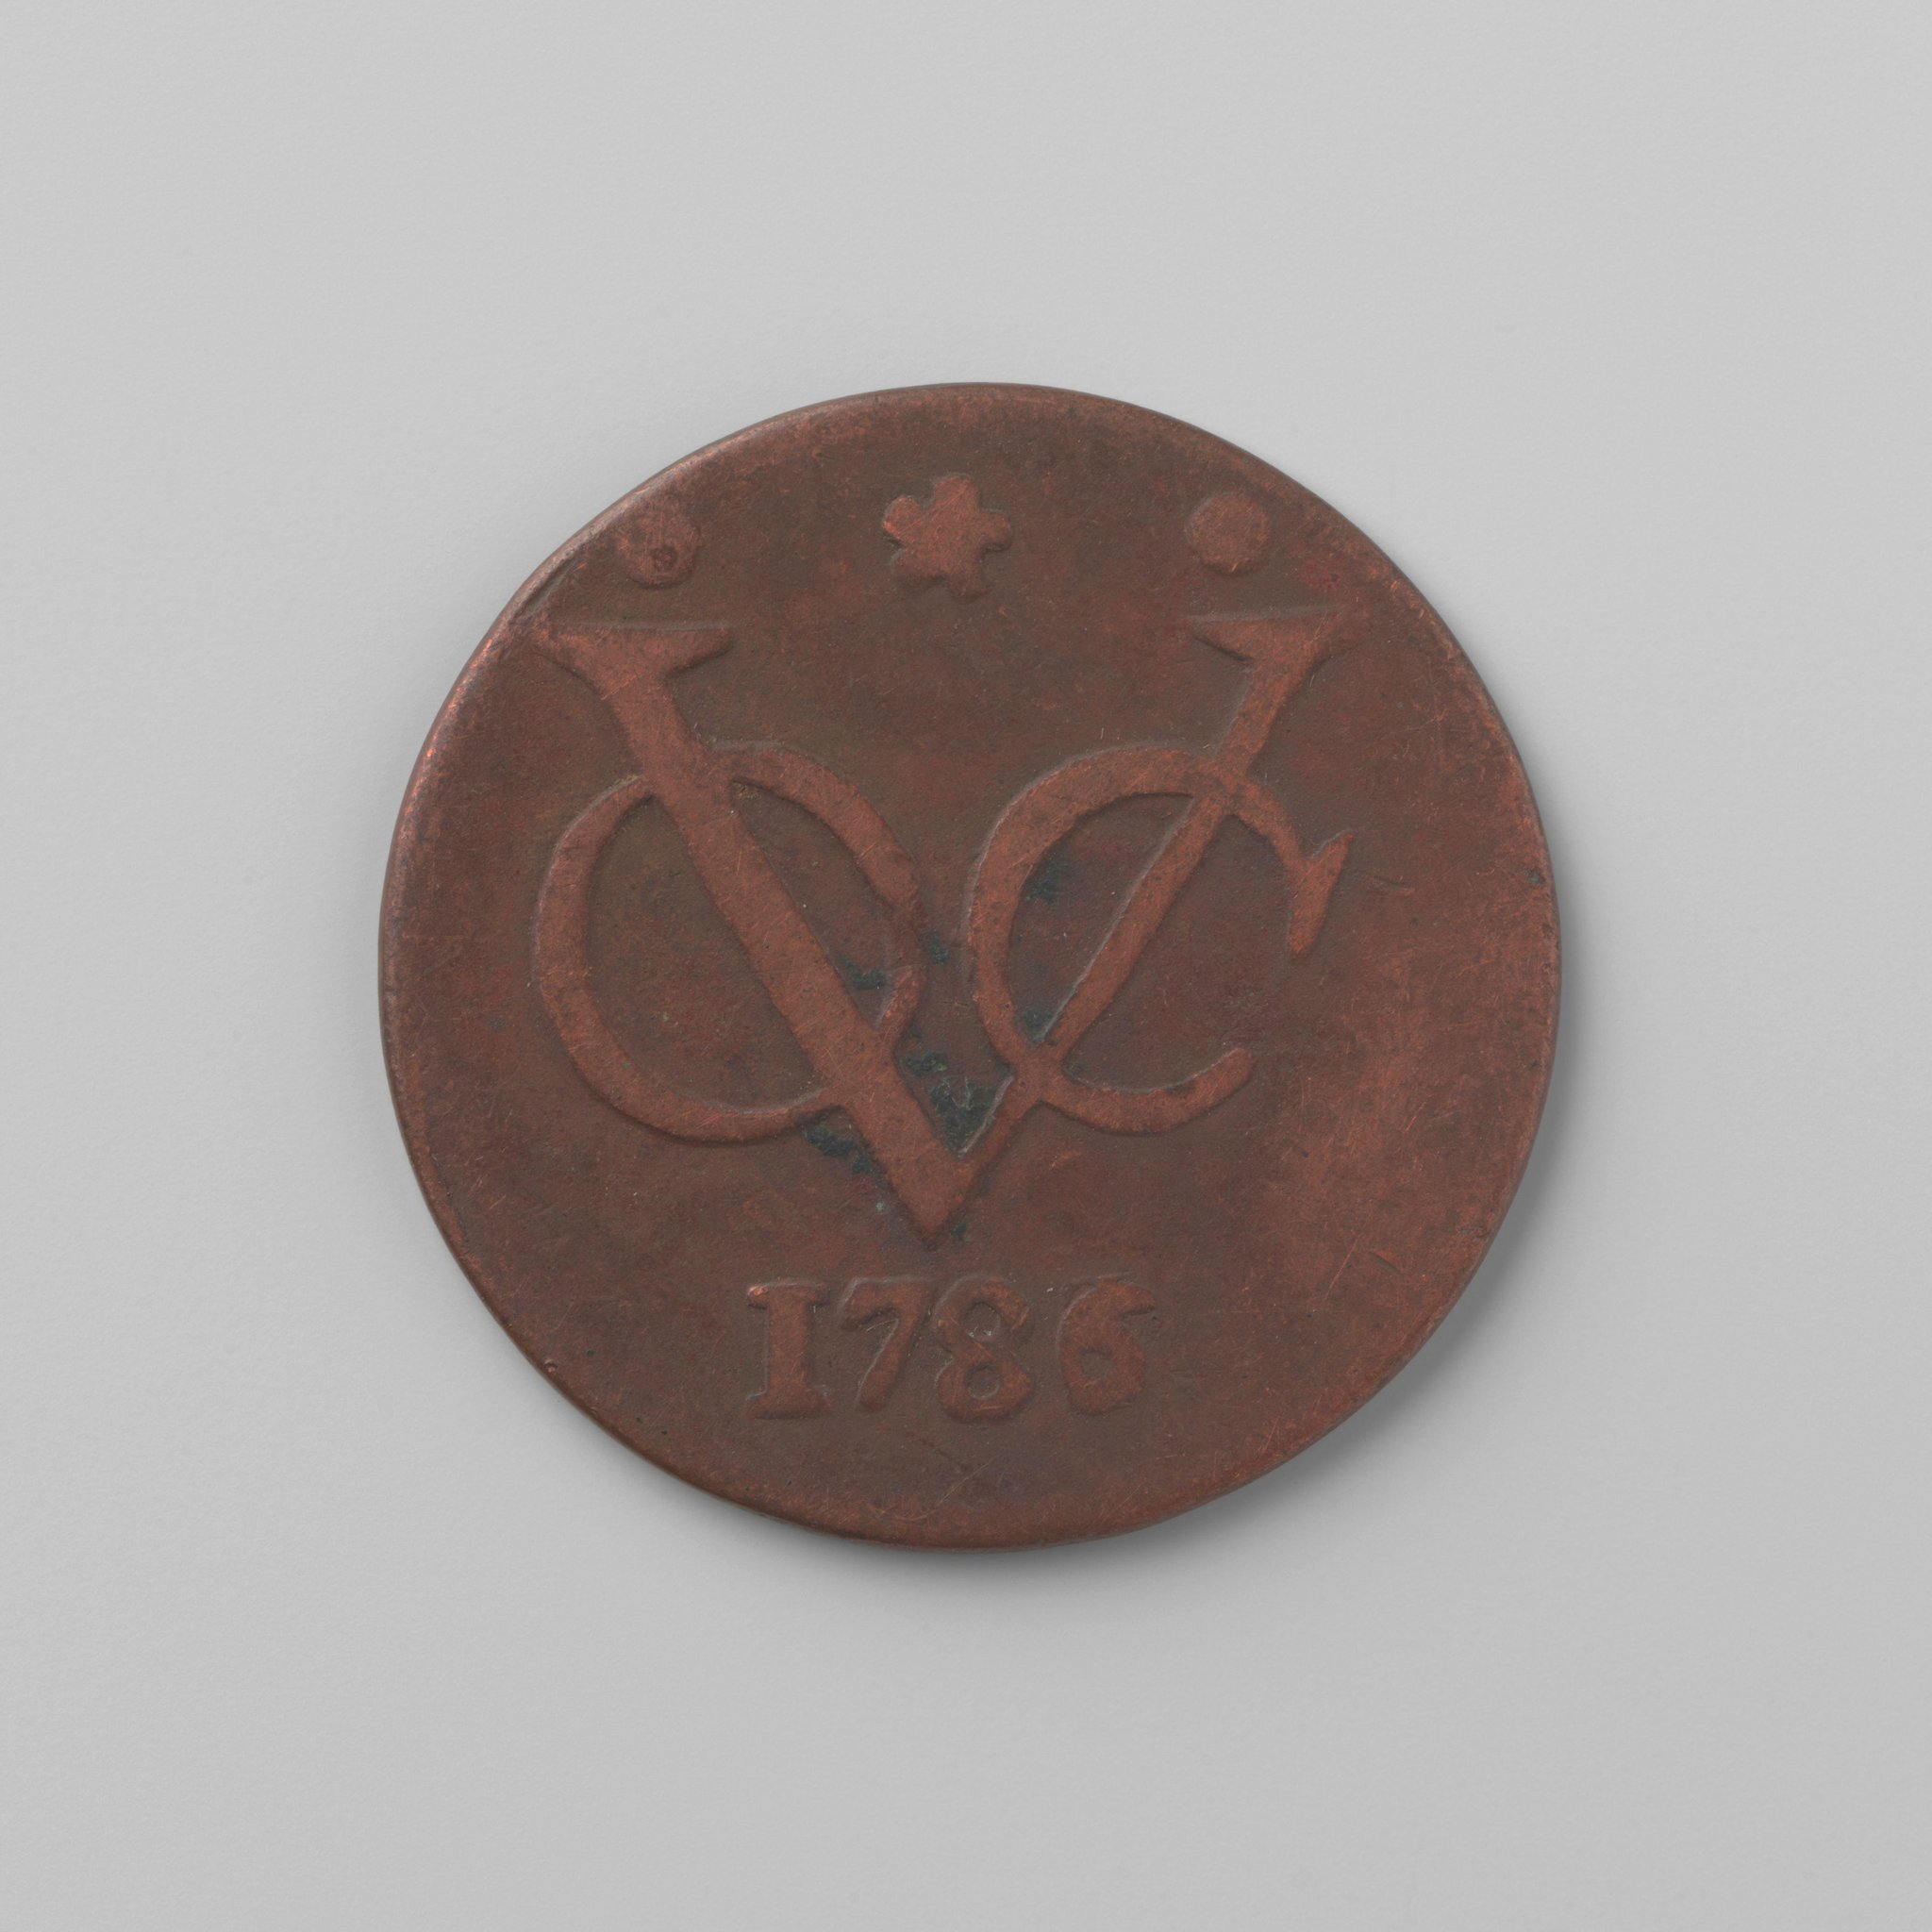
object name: coin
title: Duit van de VOC uit Westfriesland,1786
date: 1786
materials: copper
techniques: striking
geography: hoorn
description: Koperen munt. Voorzijde: gekroond wapenschild van Westfriesland. Keerzijde: monogram van de VOC, waarboven muntteken en waaronder jaartal. Gladde rand.